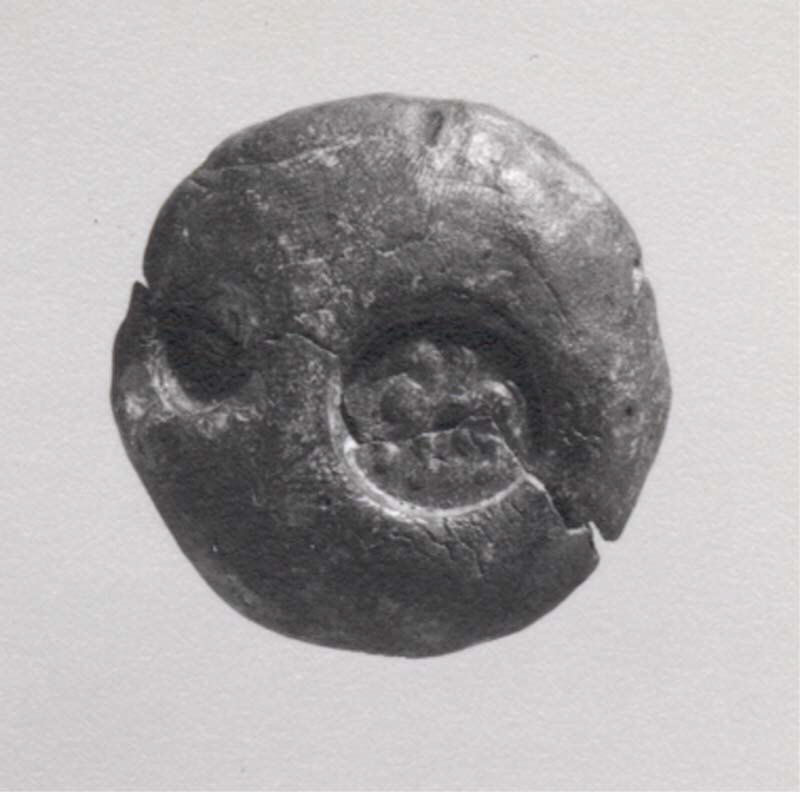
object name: sealing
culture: sasanian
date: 601-700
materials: clay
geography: iran